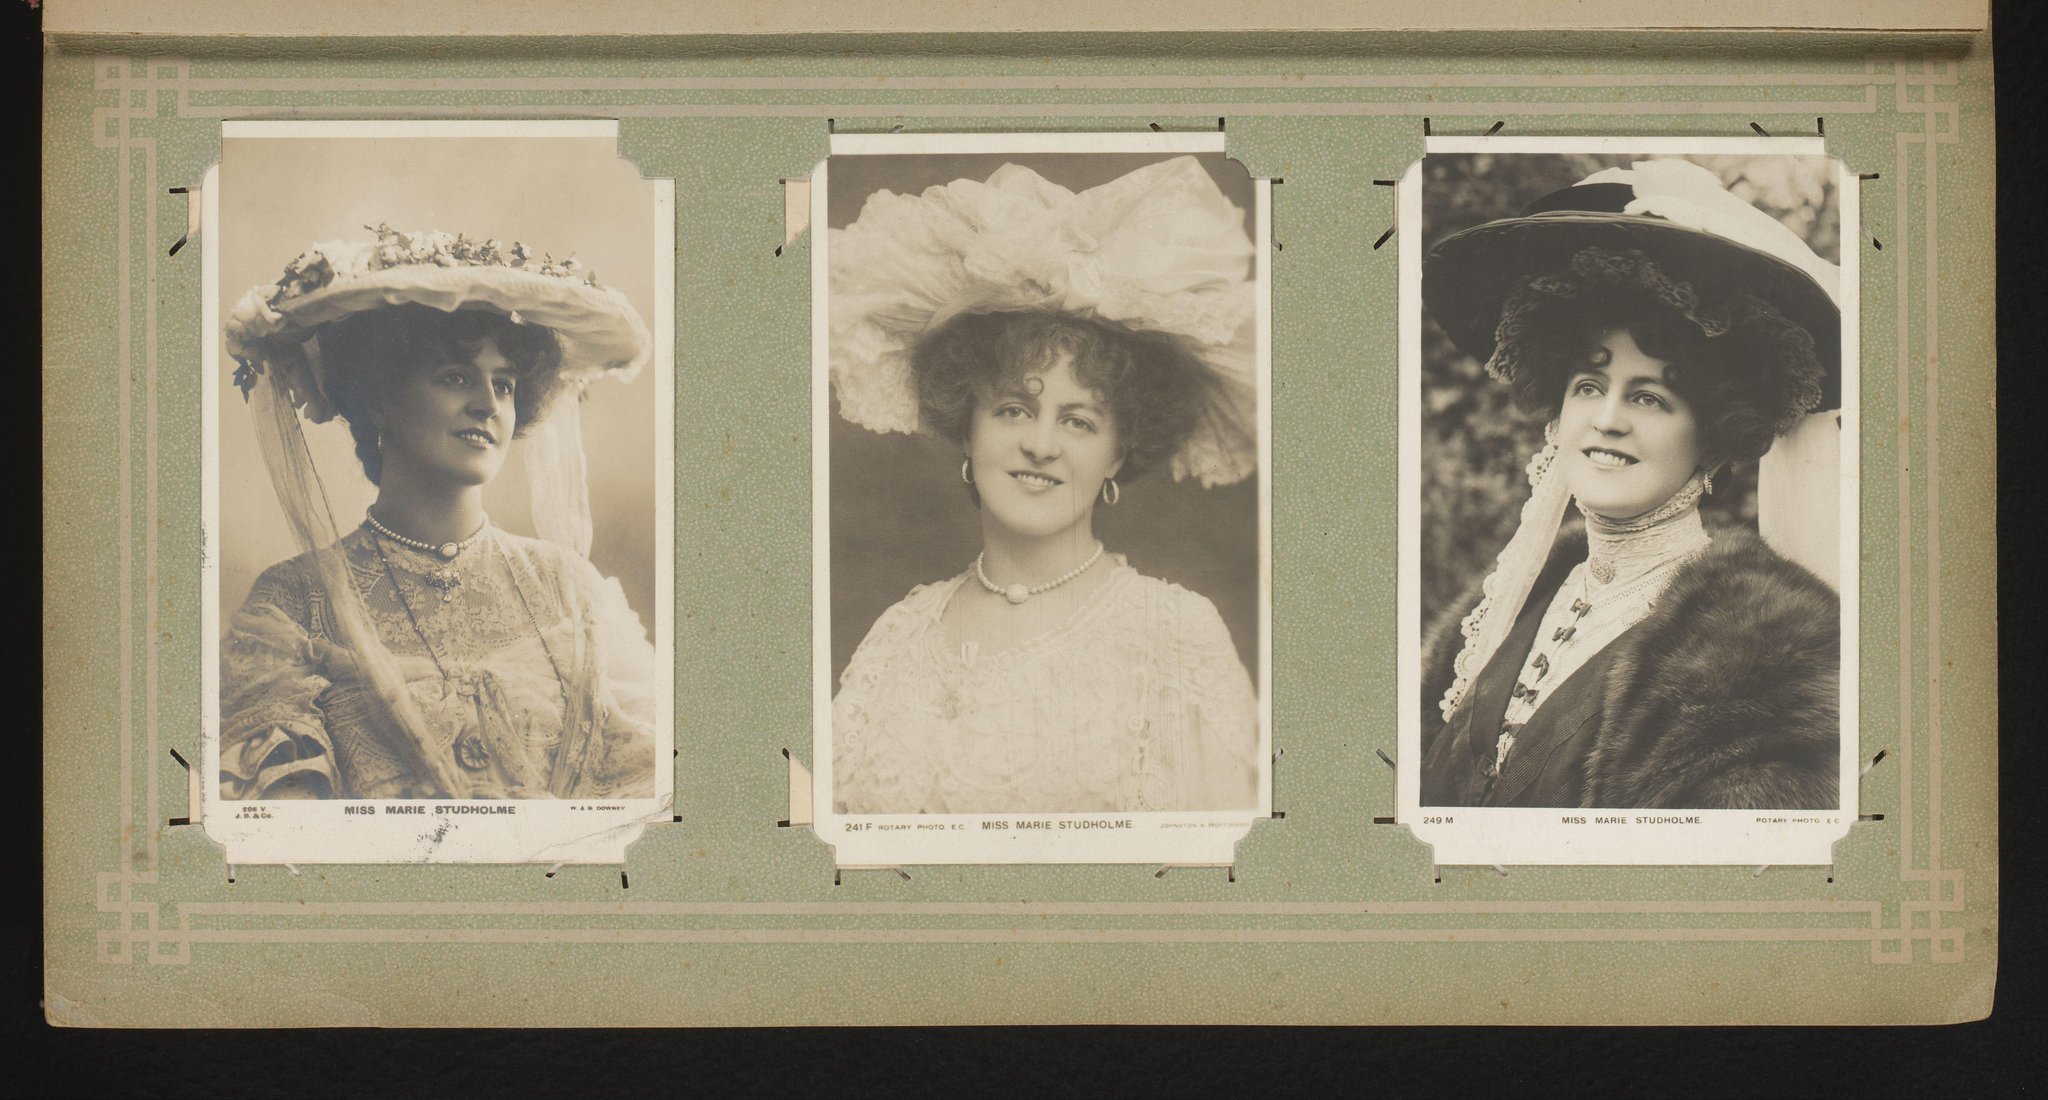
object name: ansichtkaart, prentbriefkaart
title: Drie portretten van Marie Studholme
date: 1900-1930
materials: cardboard, photographic support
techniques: gelatin silver print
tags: historical persons - bb - woman, portrait of actor, actress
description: Deze foto's maken deel uit van een album.